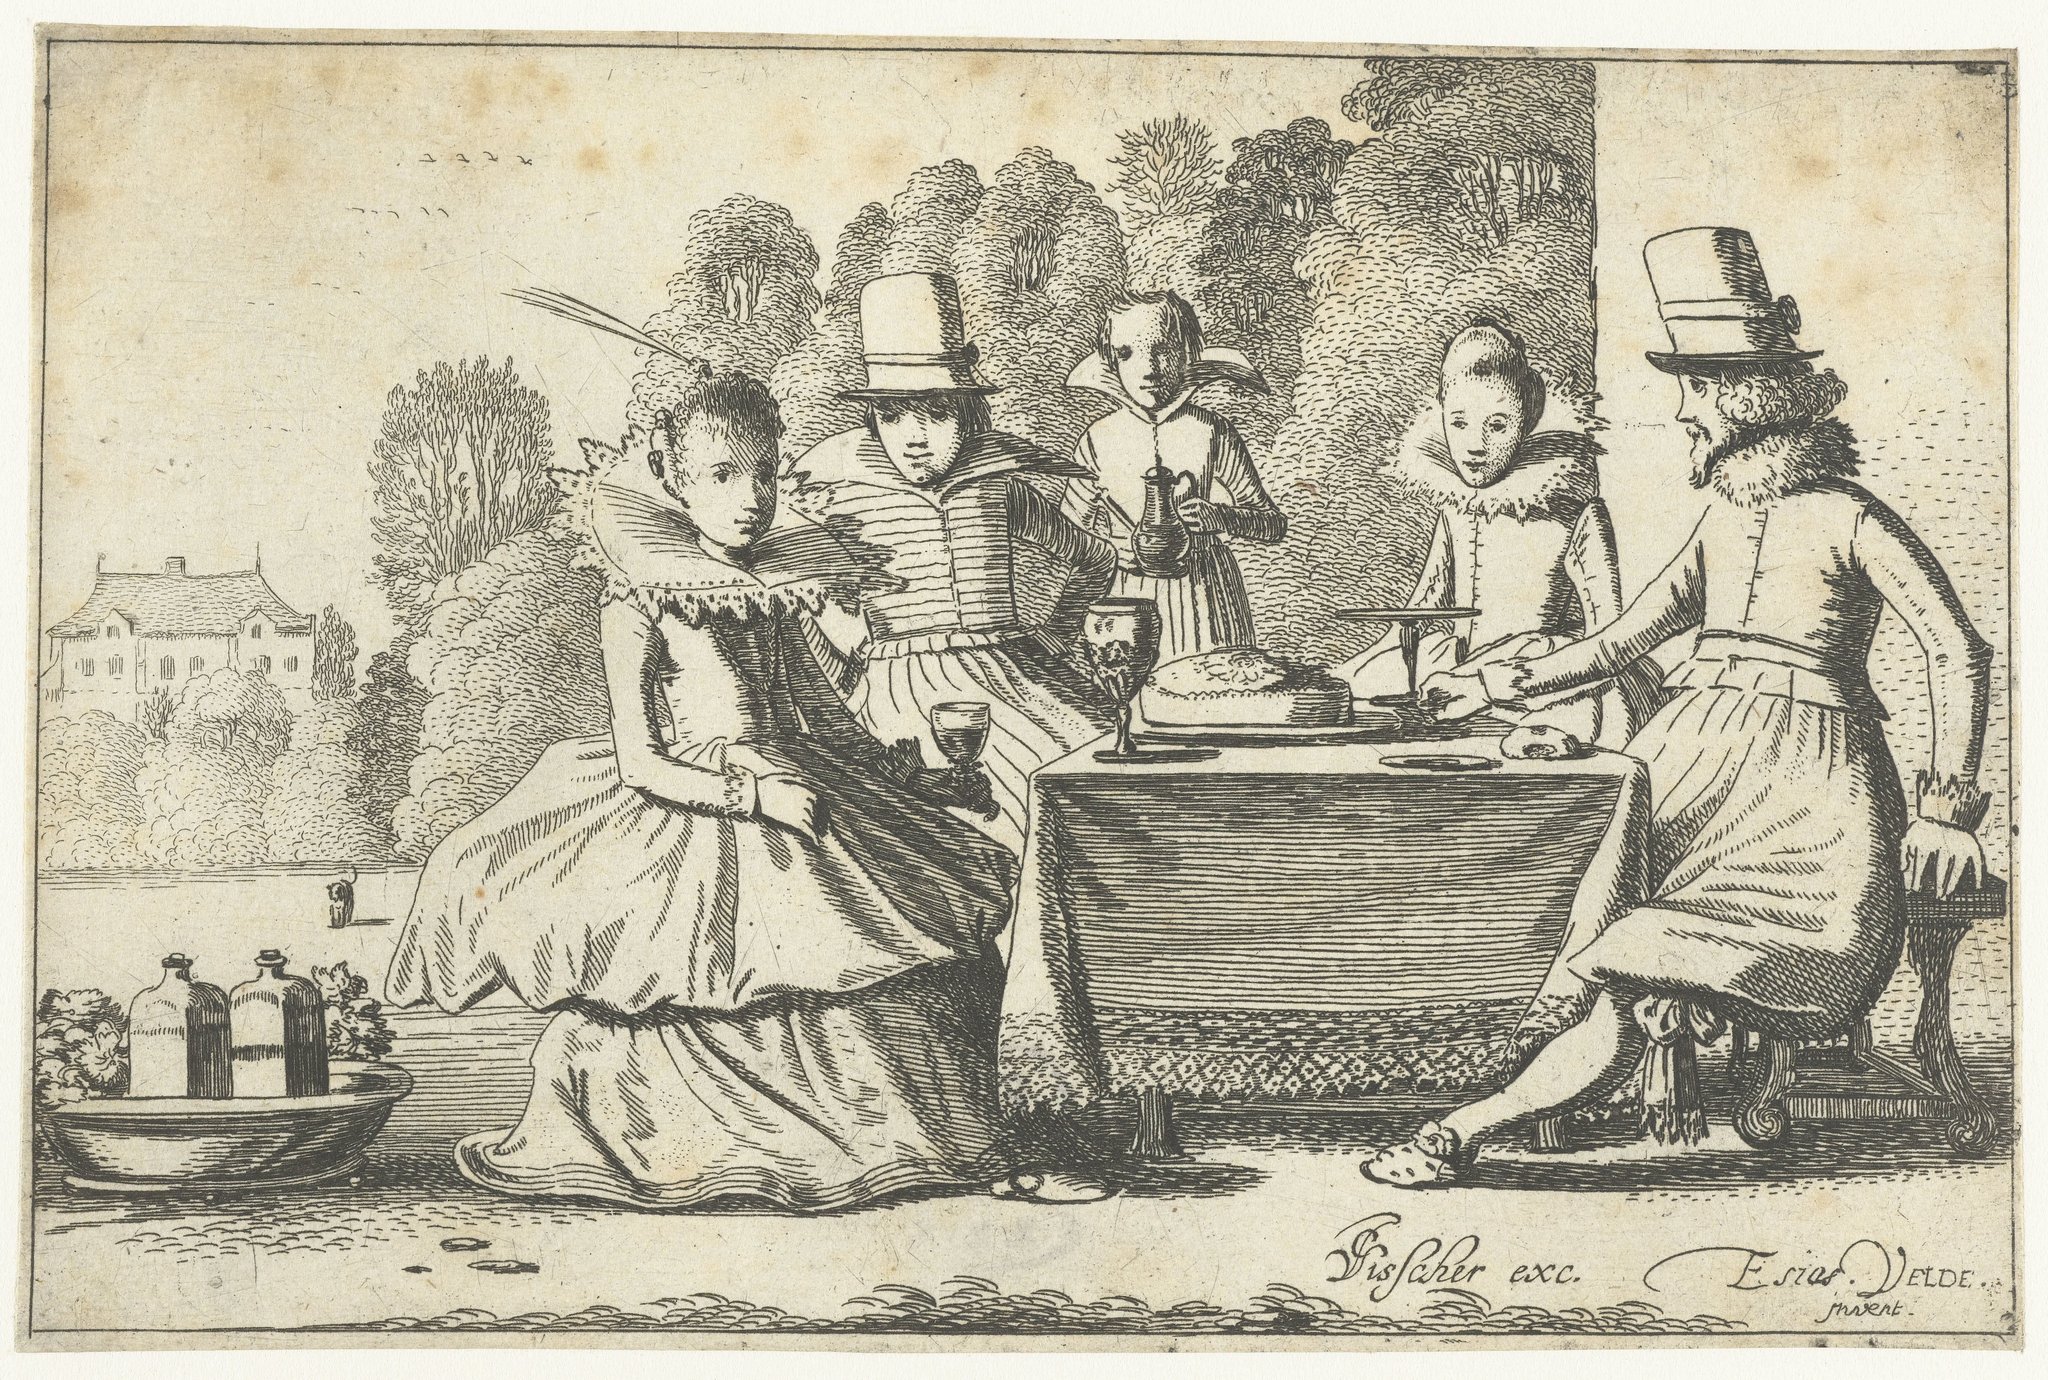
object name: print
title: Gezelschap gebruikt een maaltijd aan een tafel in een tuin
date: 1615-1620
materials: paper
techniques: etching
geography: netherlands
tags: visiting; receiving guests; elegant company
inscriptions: collector's mark: Lugt 964